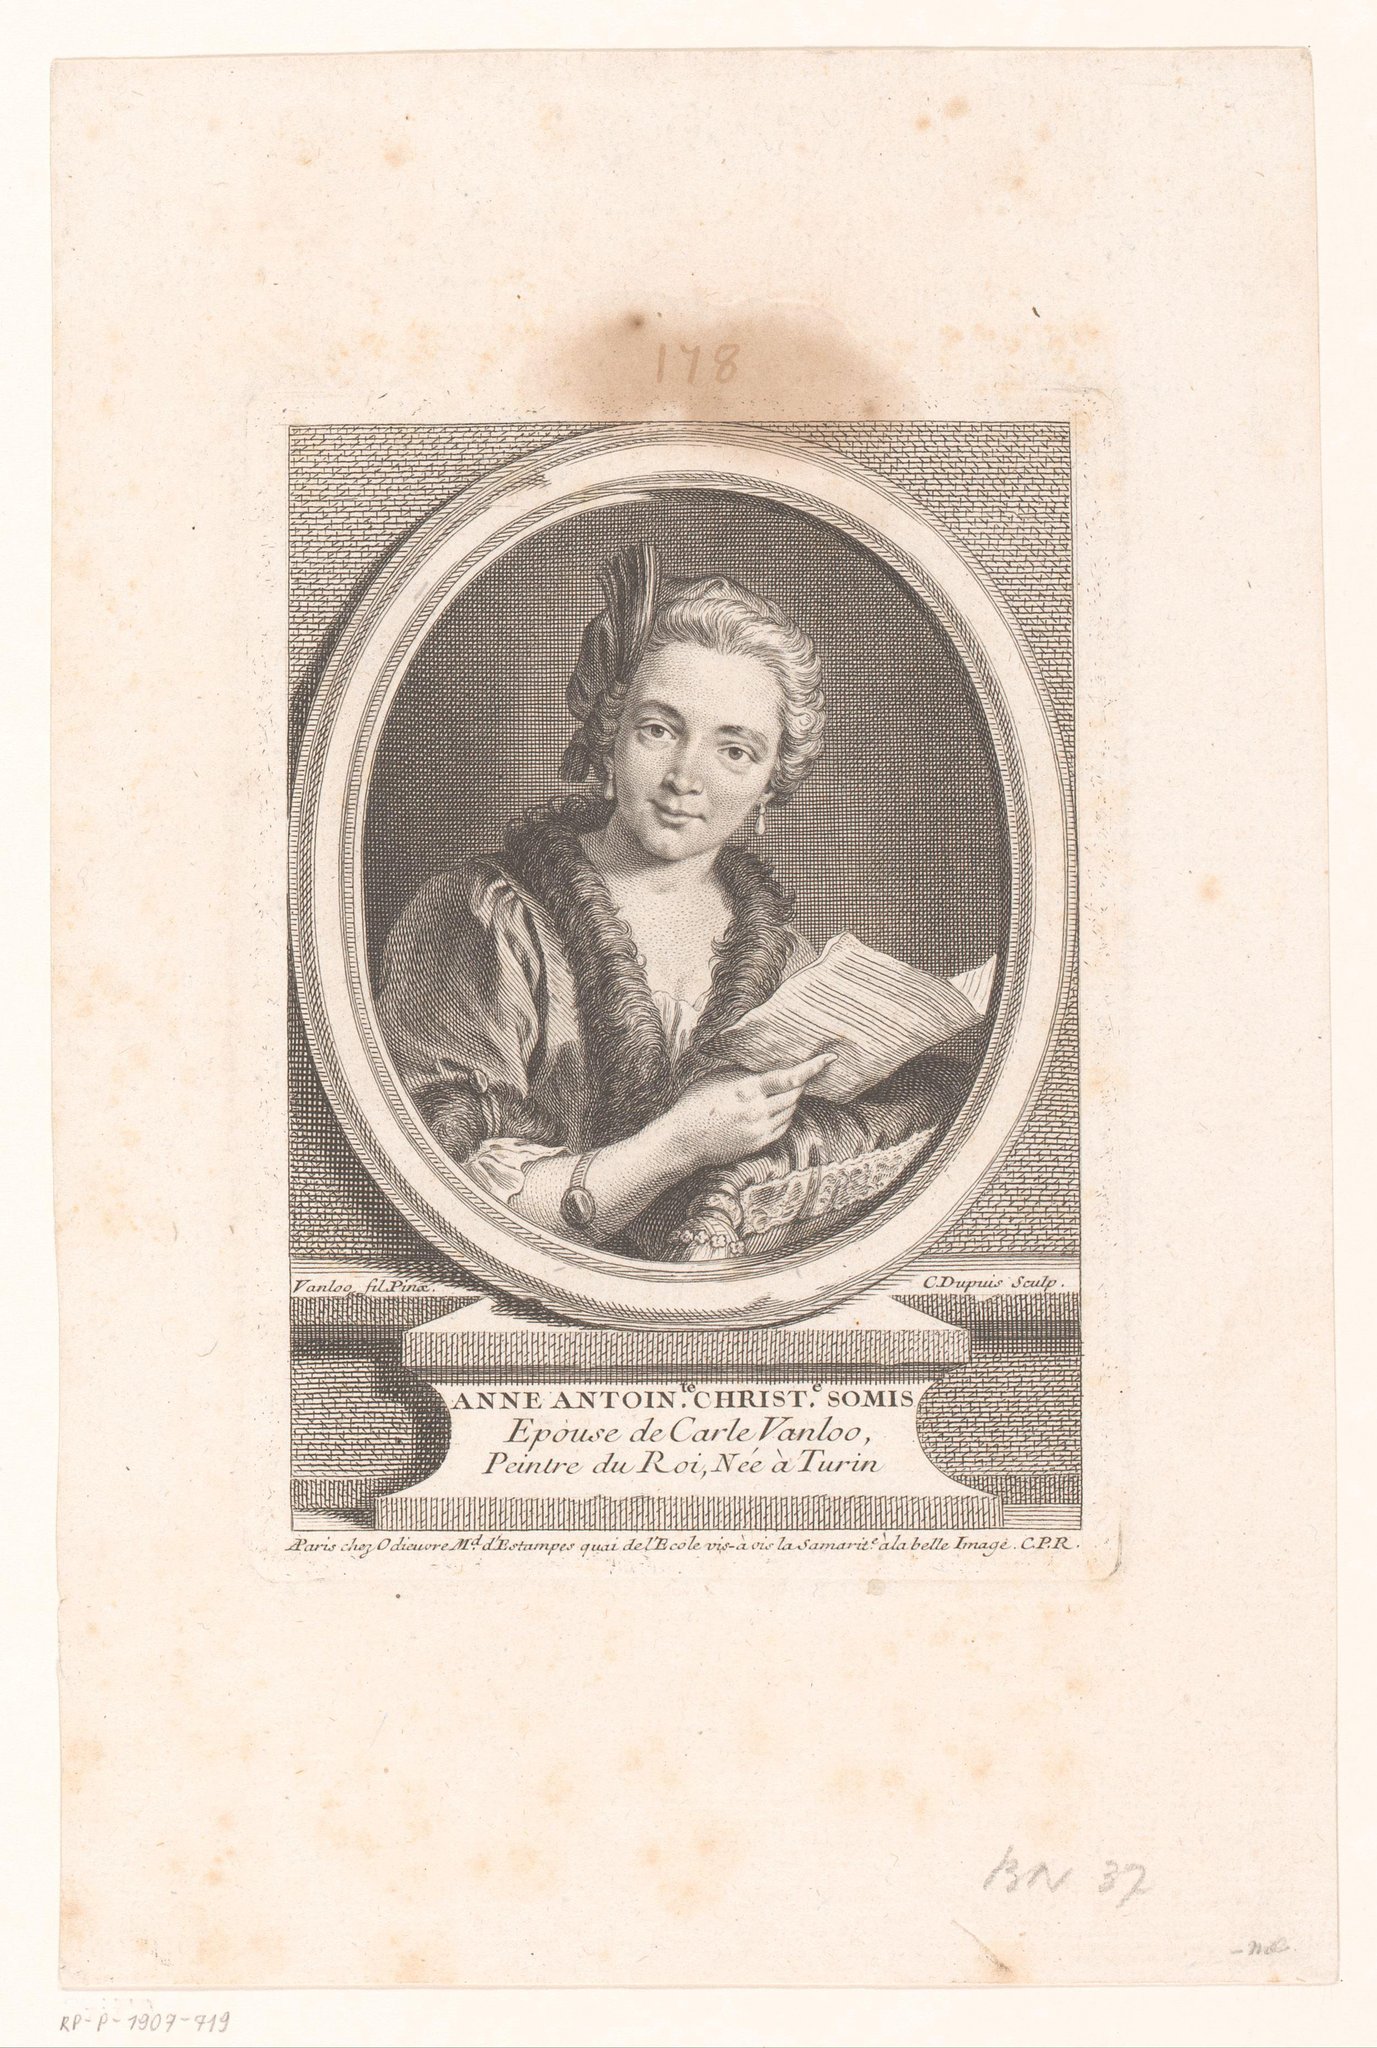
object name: print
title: Anne Antoin.te Christ.e Somis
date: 1740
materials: paper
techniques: engraving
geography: paris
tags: historical persons - bb - woman, ornament ~ medallion, female singer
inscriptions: inscription: ‘178’, collector's mark: Lugt 2228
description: Prent uit: Dreux du Radier, Jean-François. L'Europe illustré, contenant l'histoire abregée des souverains, des princes, des prélats, des ministres, (...) en Europe: dans le XVe. siècle compris, jusqu'à présent. Parijs: Michel Odieuvre en Jean-Luc Nyon, ca. 1740, dl. 5.